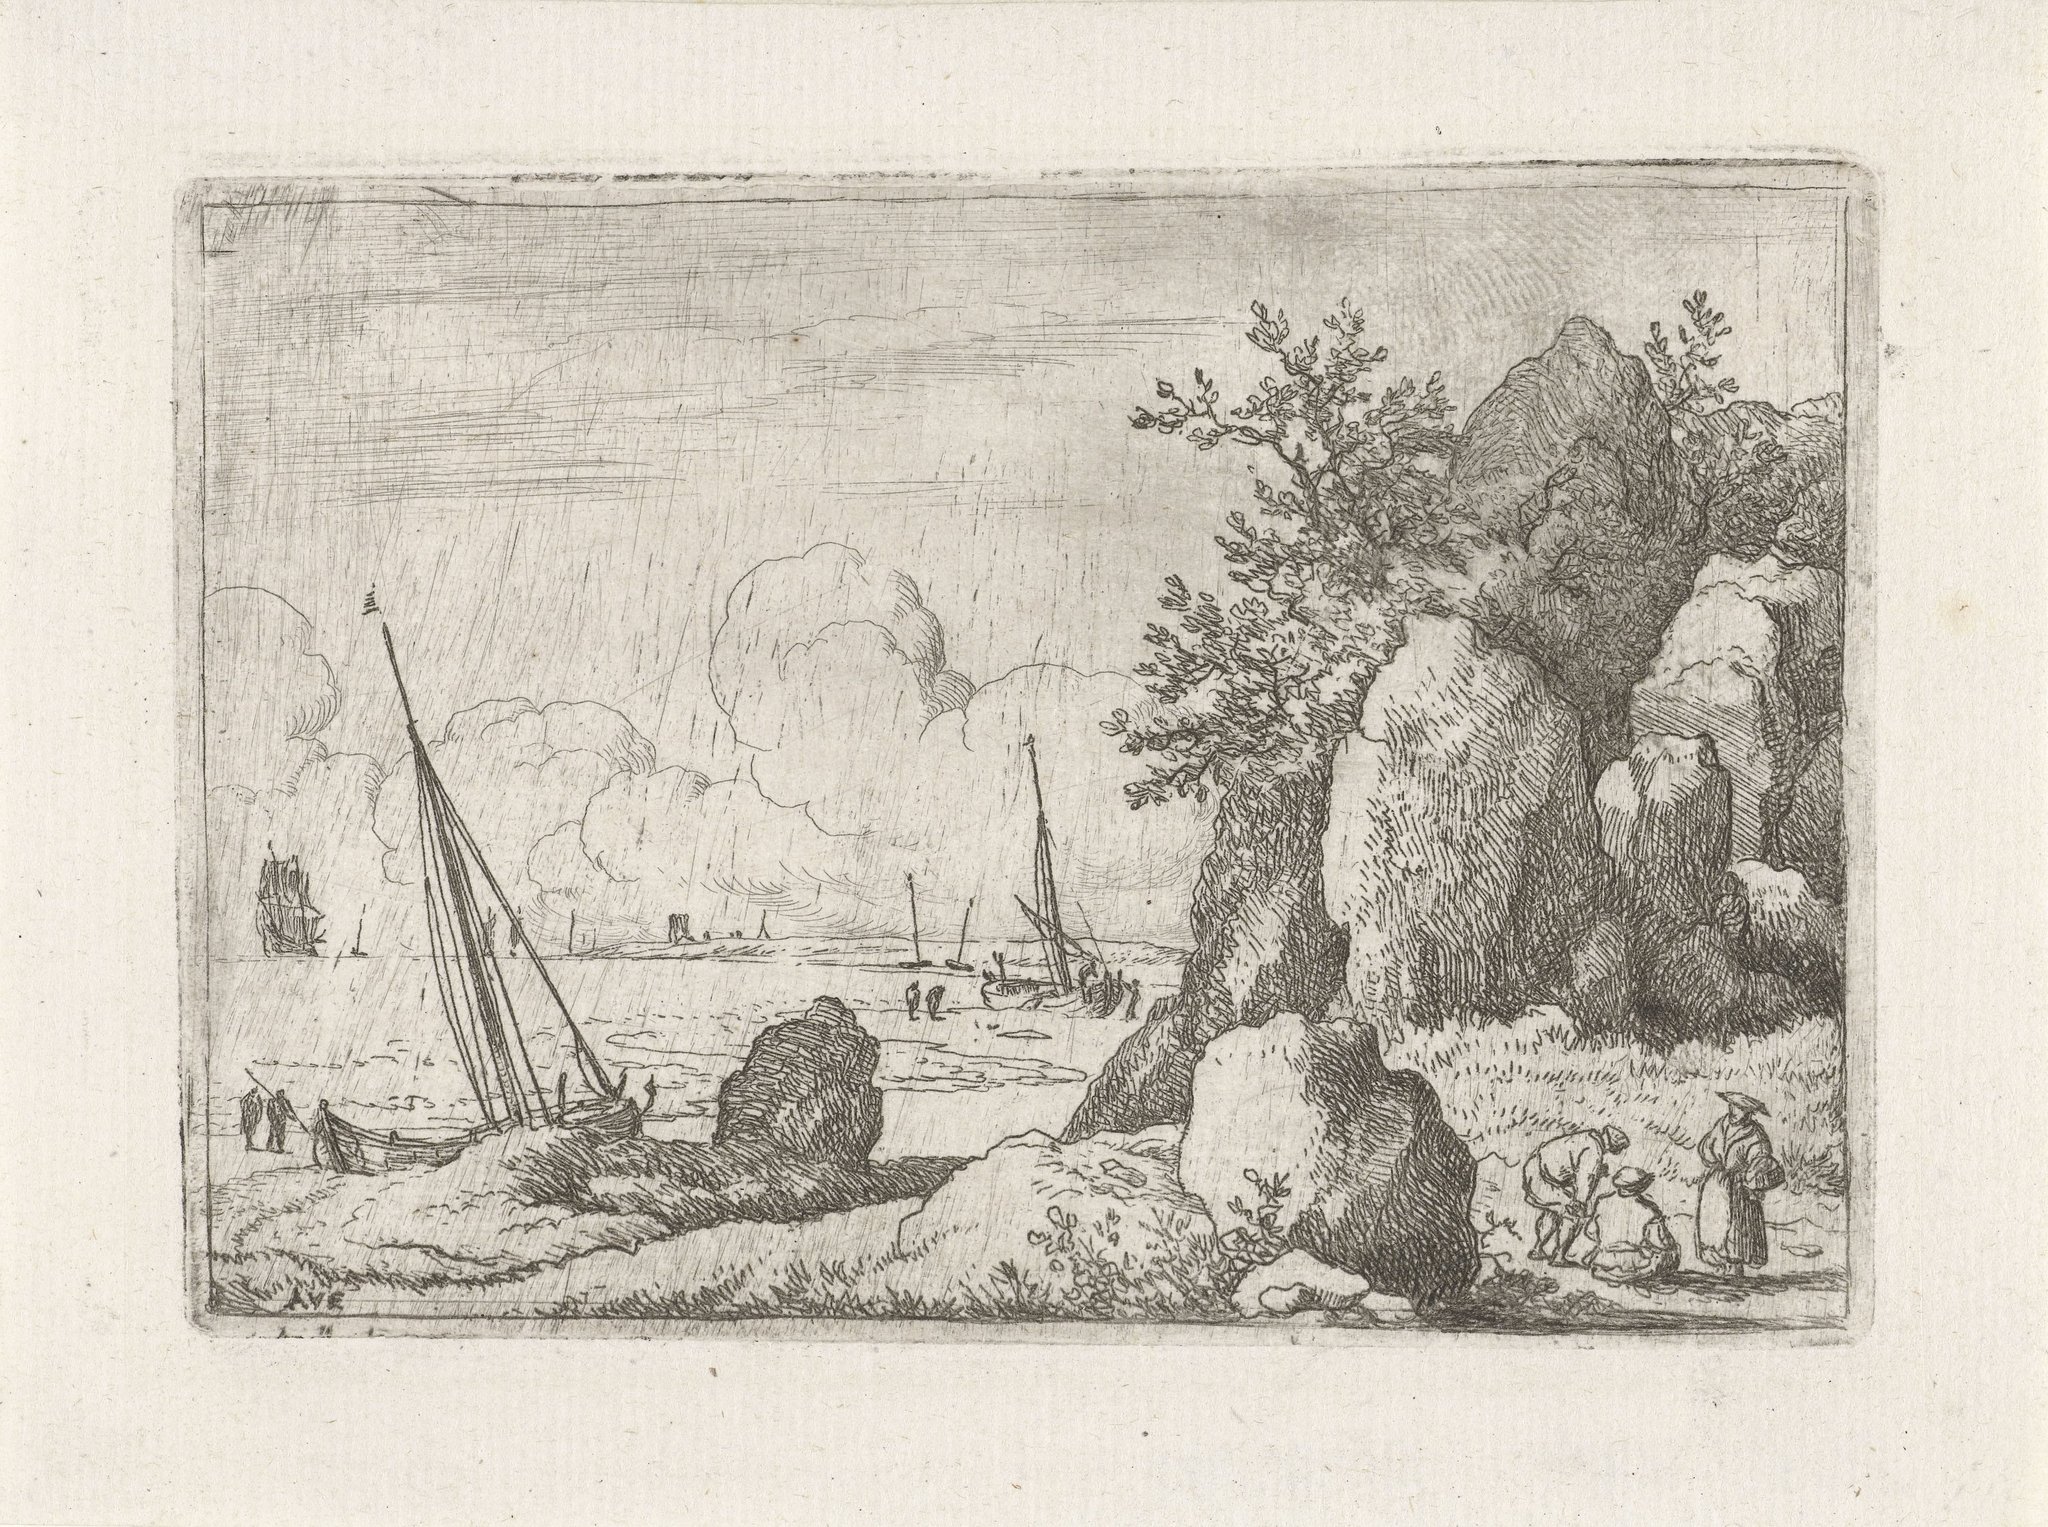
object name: print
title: Zeegezicht met zeilschepen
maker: allaert van everdingen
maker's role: draughtsman, painter, print maker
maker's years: 1621-1675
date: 1631-1675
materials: paper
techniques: etching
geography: netherlands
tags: sea (seascape) (+ landscape with figures, staffage)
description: Landschap met rotspartij en zeegezicht met enkele zeilschepen. Op het land, naast een rots, zijn drie personen afgebeeld.